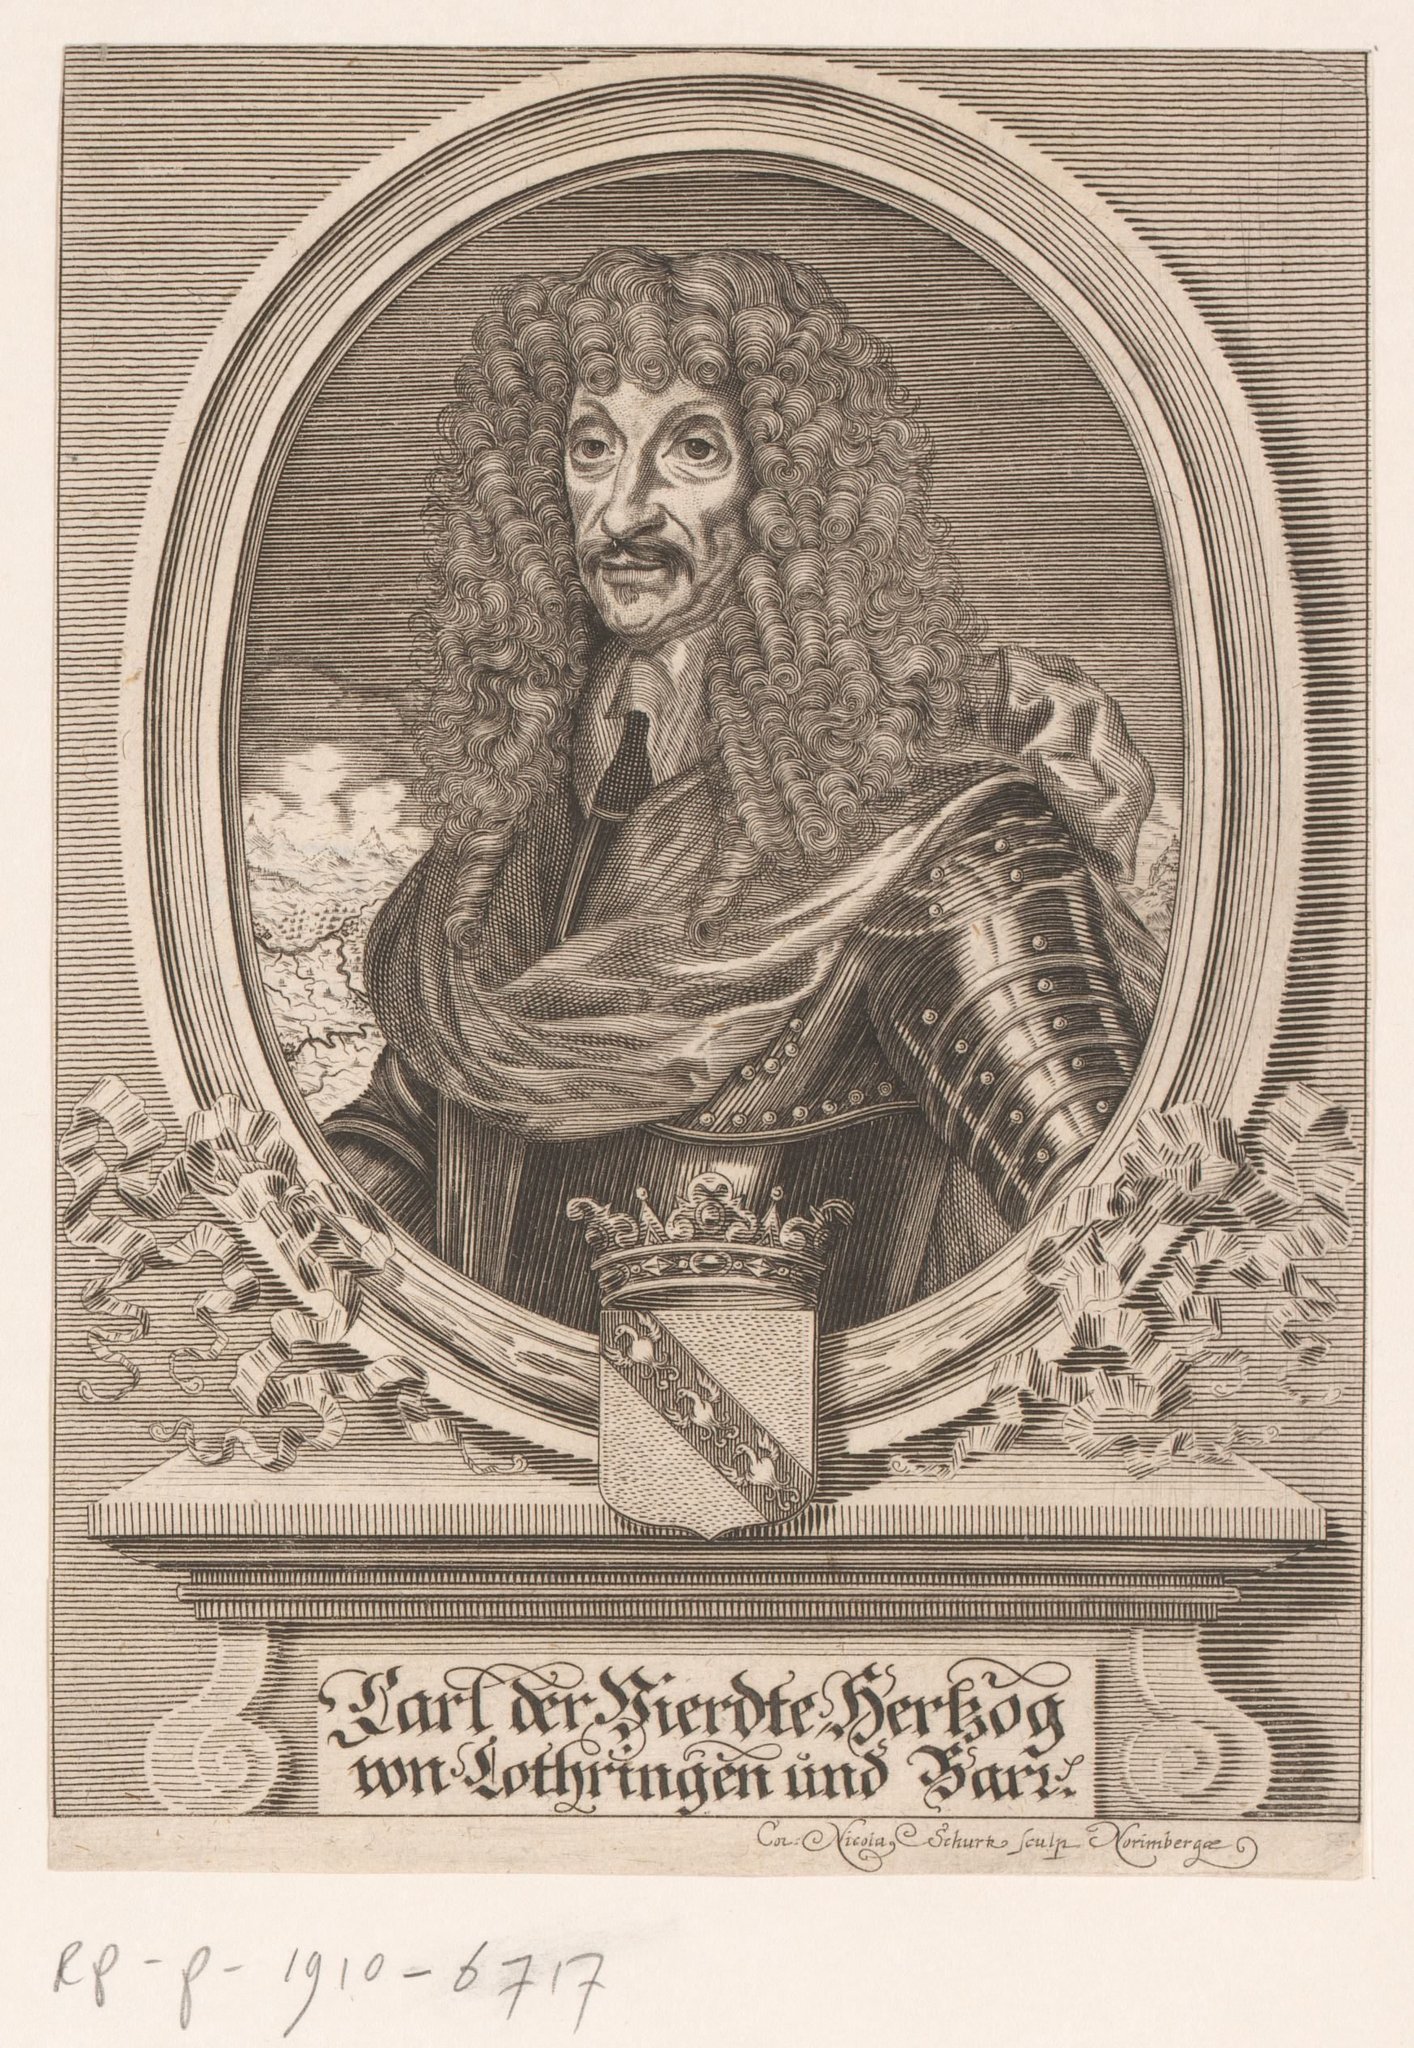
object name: print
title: Portret van Karl IV van Lotharingen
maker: cornelis nicolaus schurtz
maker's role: print maker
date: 1625-1699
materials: paper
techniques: engraving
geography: nuremberg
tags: karel iv hertog van lotharingen, historical persons, armorial bearing, heraldry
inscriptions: collector's mark: Lugt 2228